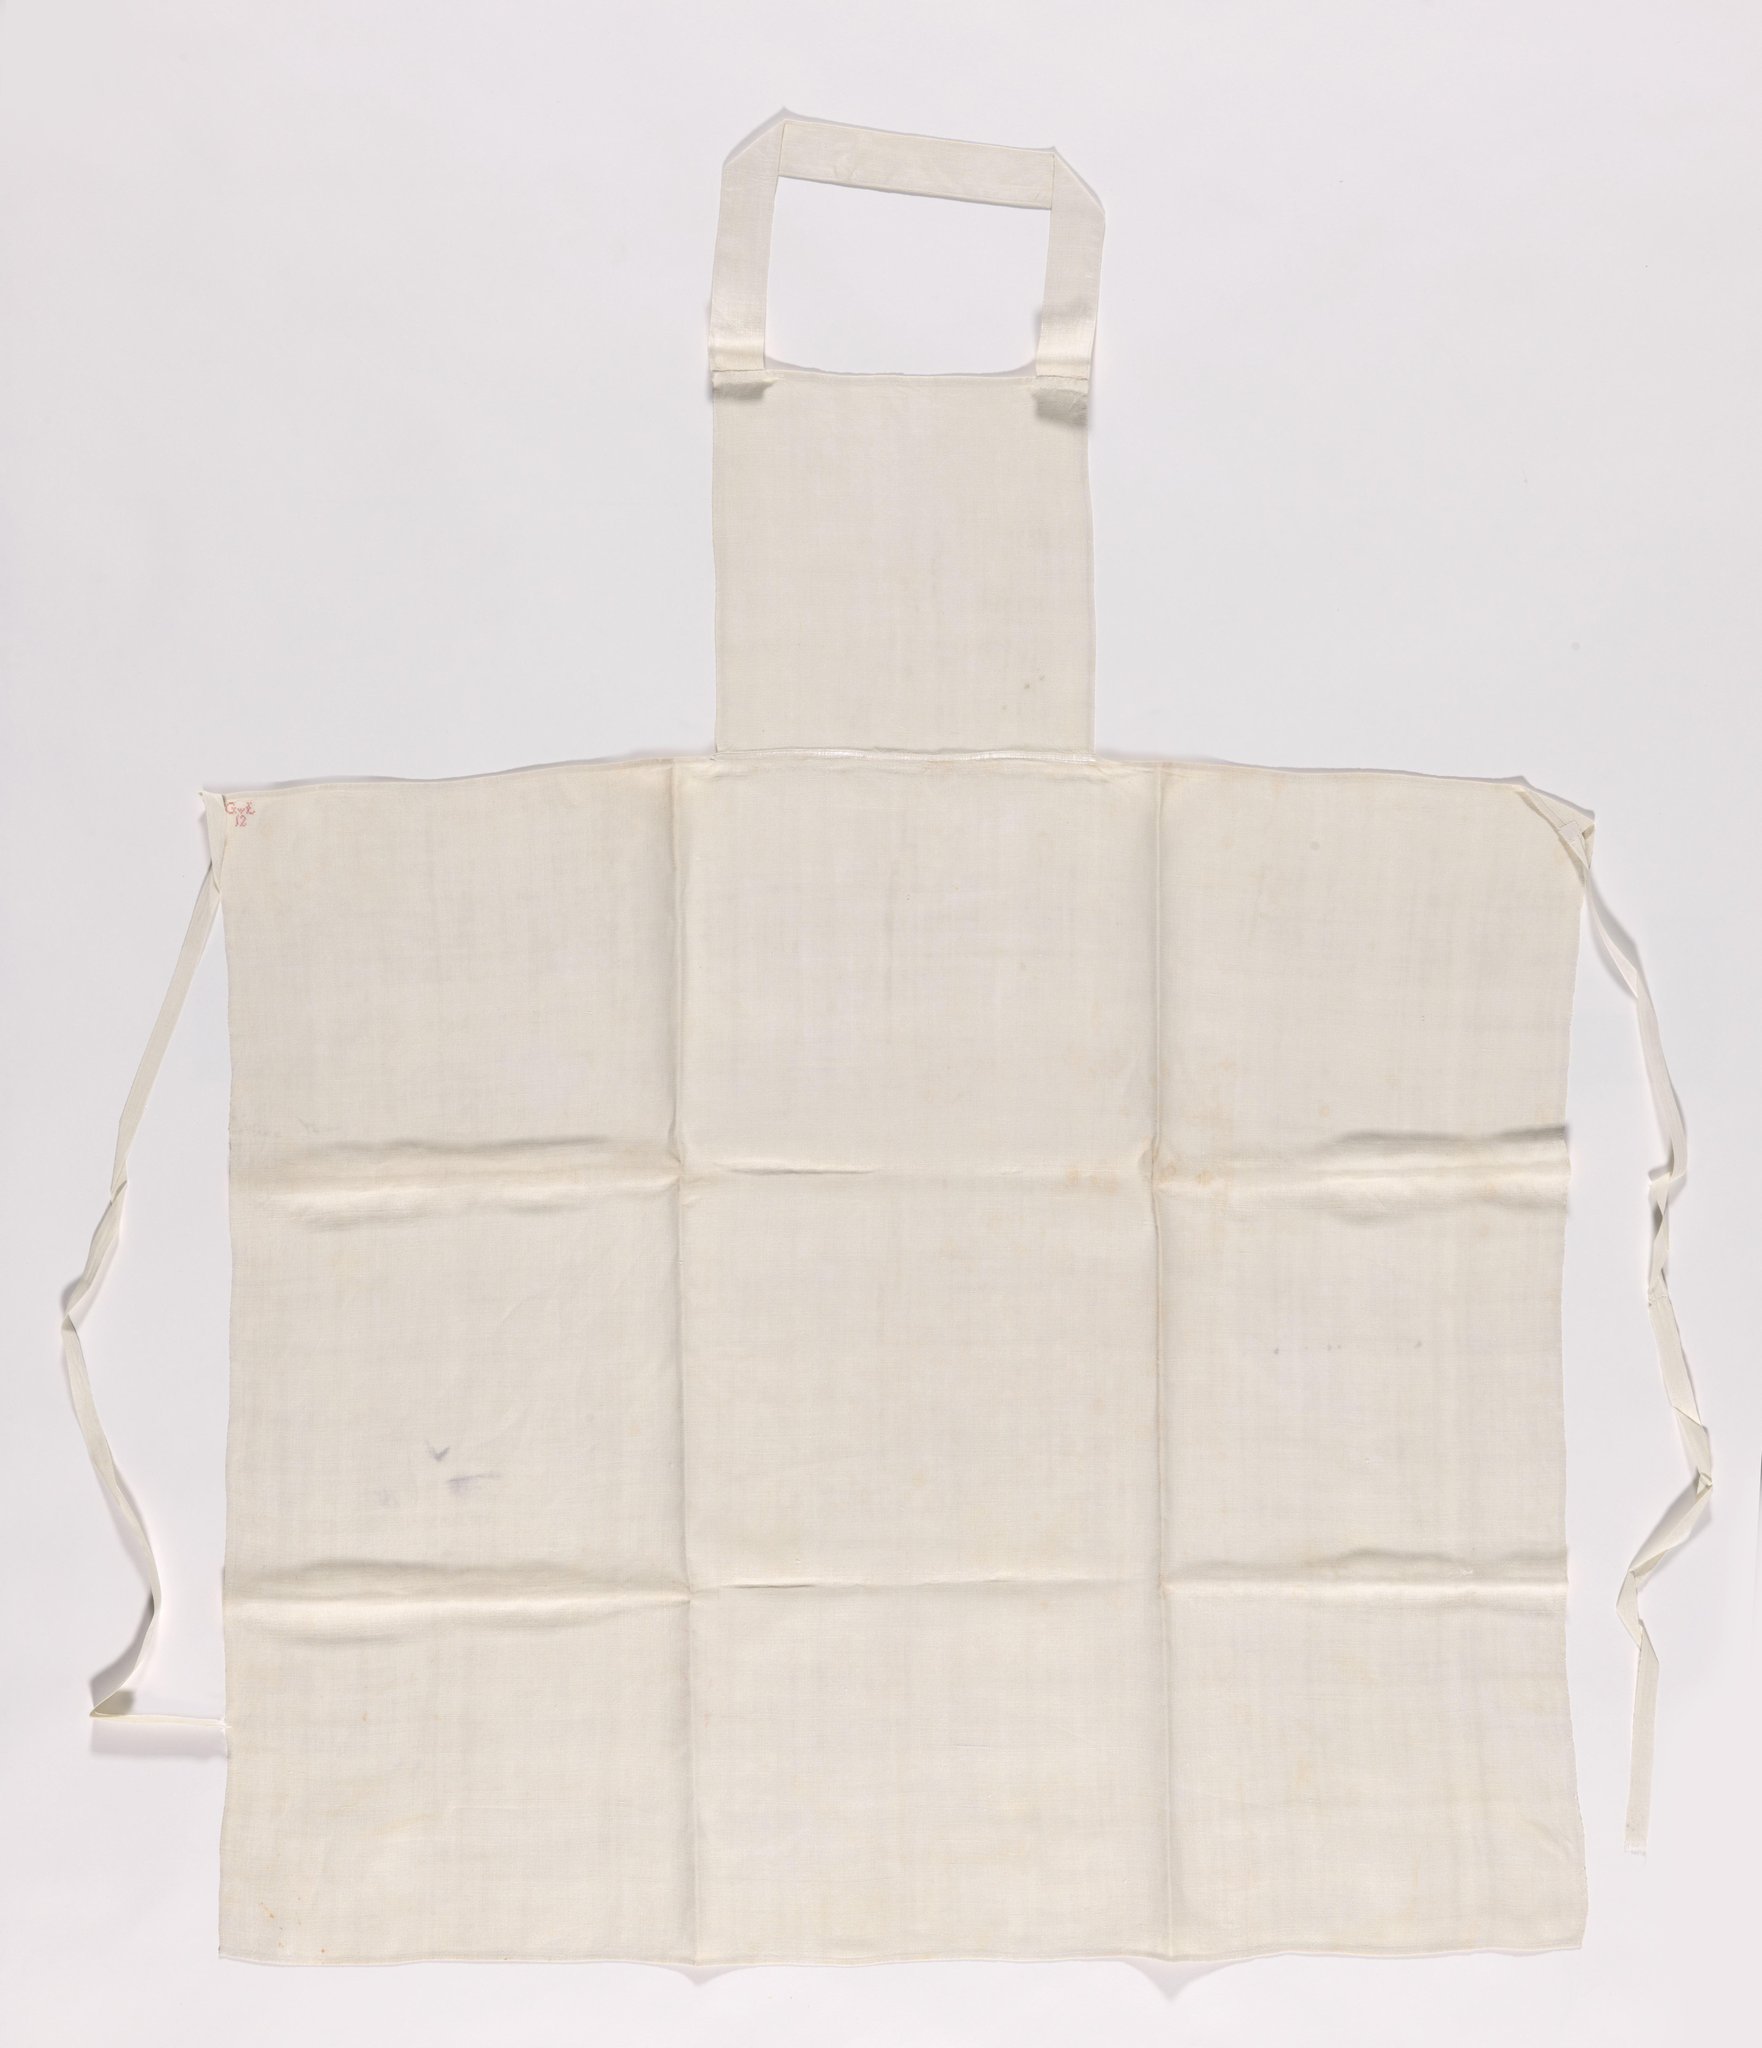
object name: apron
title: Schort geweven van ruw linnen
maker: Anonymous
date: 1400-1950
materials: linen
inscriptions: mark: ‘GvL 12’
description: Schort van ruw geweven linnen, bestaande uit een rechthoekige schoot en borststuk voorzien van een halsband en smallere, iets fijner geweven striklinten. Gemerkt in rode kruissteek: GvL 12 (Gevers van Lennep)